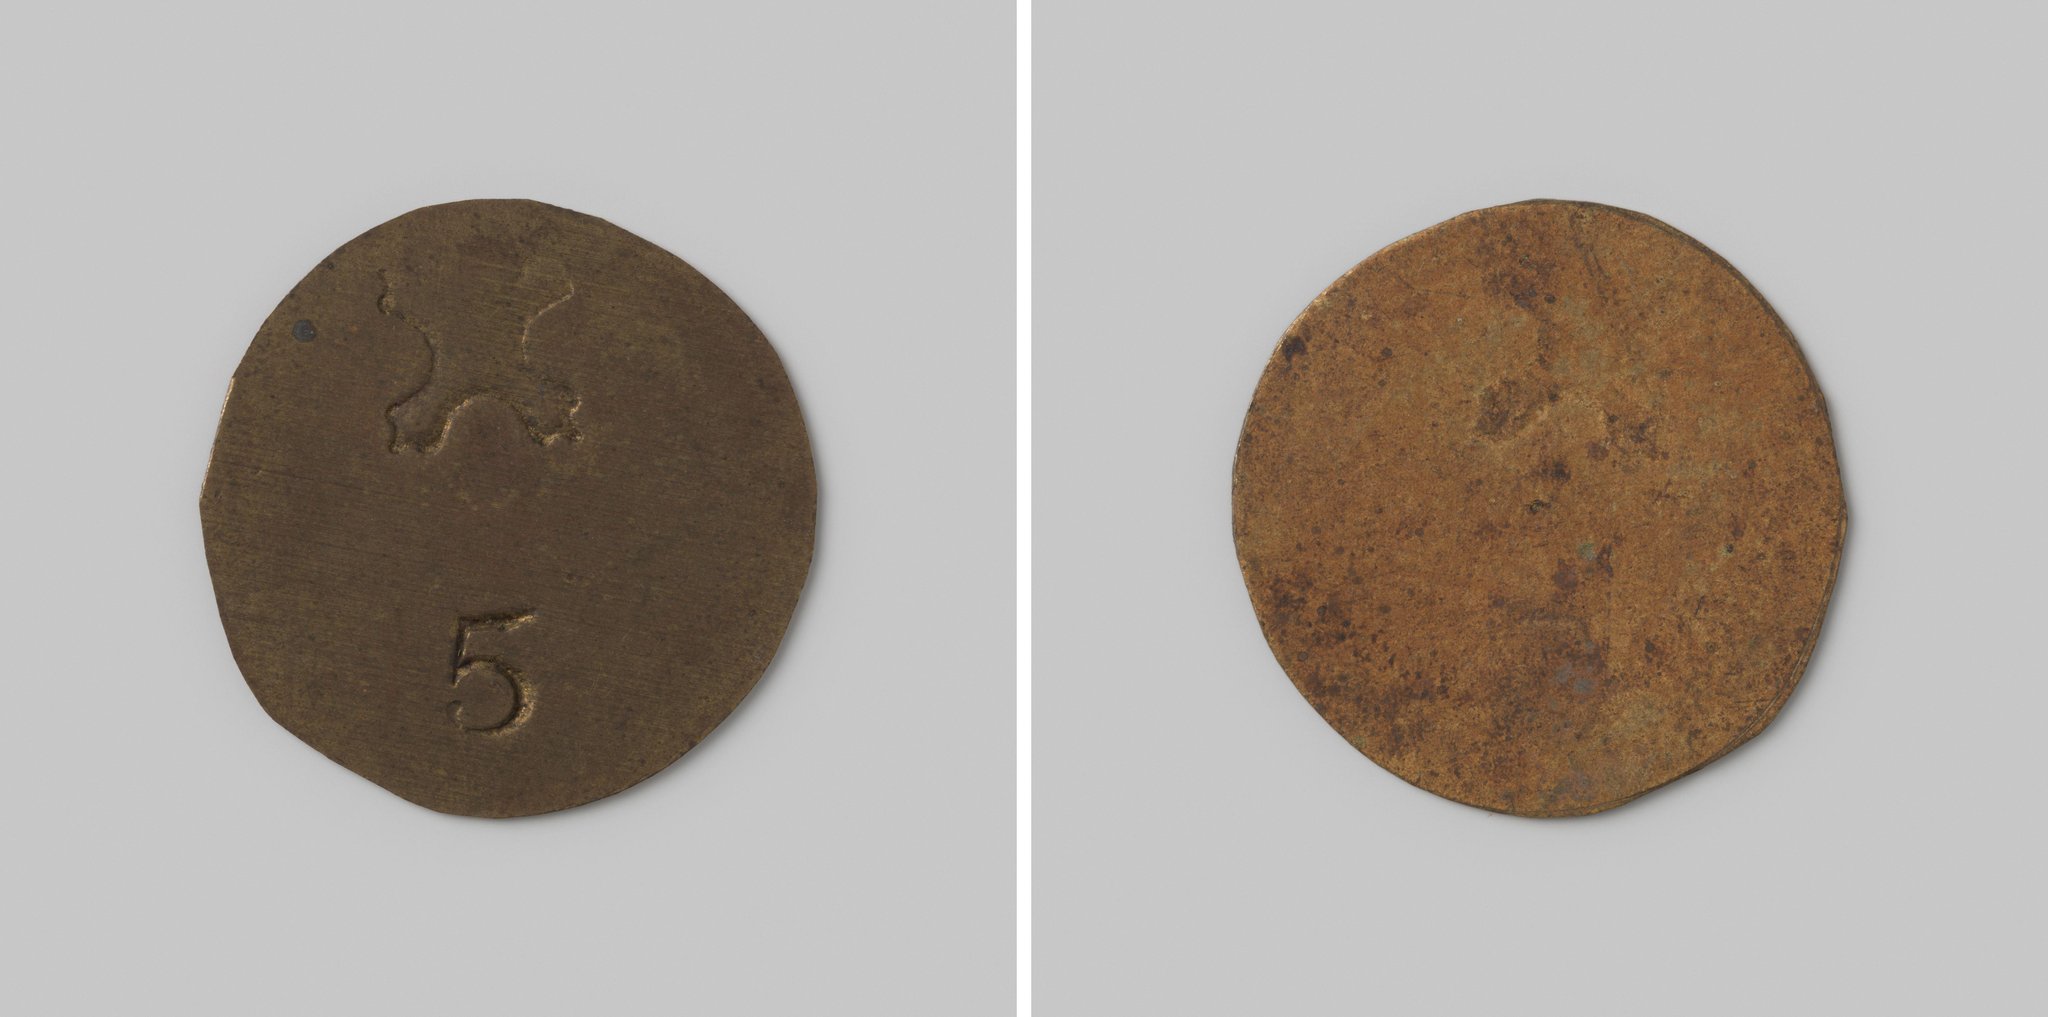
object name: monetary token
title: Betaalpenning van vijf cent van de Coöperatieve Winkelvereeniging De Volharding te Veenendaal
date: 1875-1900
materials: brass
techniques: printing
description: Rond messing plaatje met instempelingen (andreaskruis) / 5